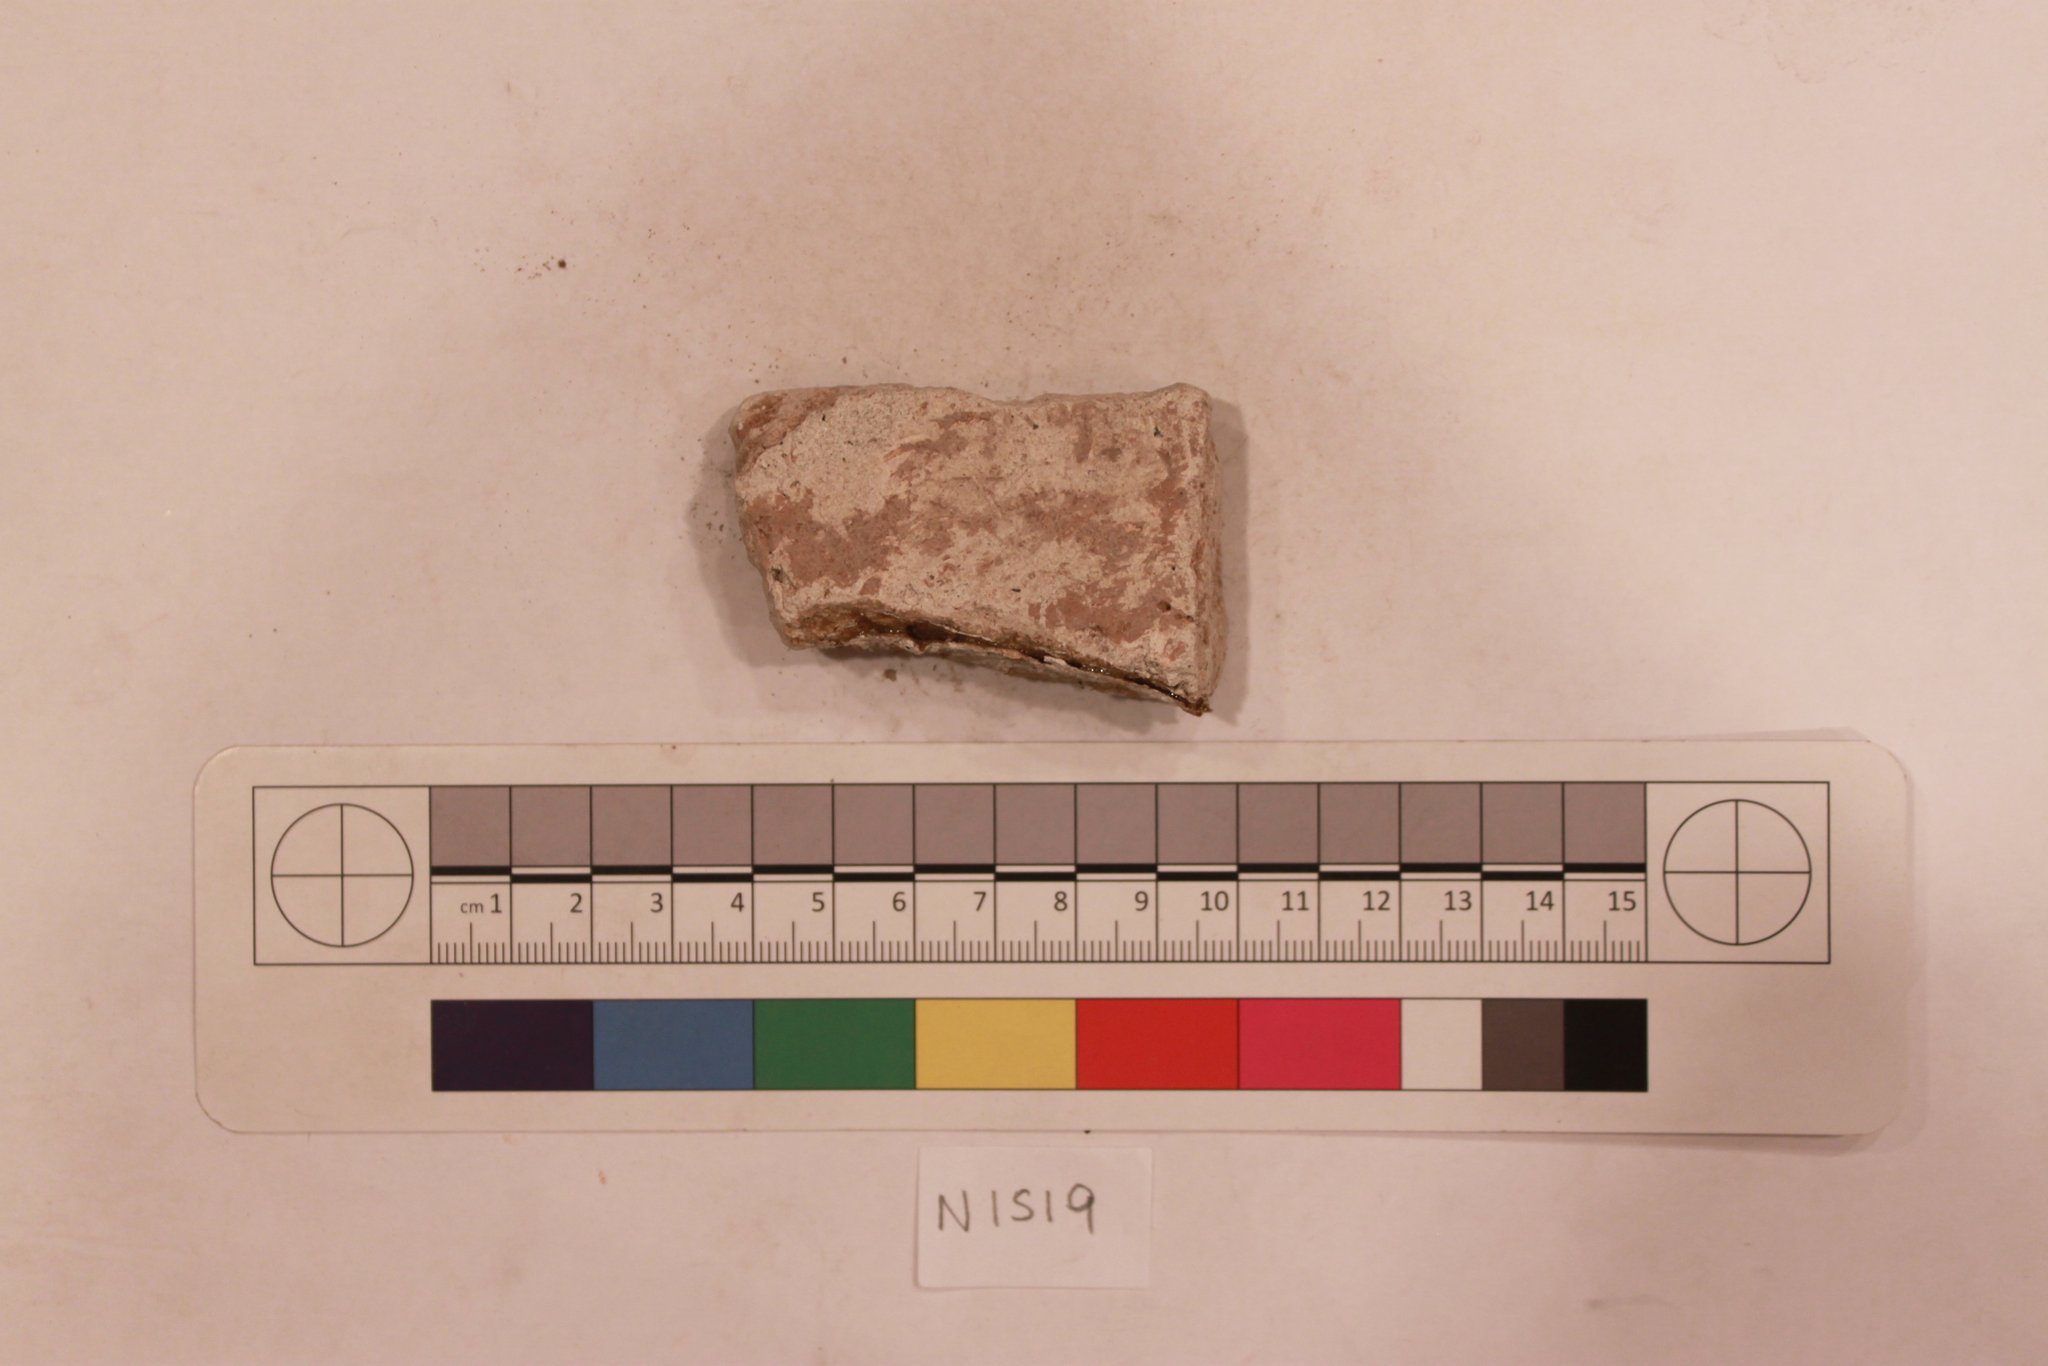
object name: fragment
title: Stucco Fragment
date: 701-1200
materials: plaster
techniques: carving, painting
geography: iran